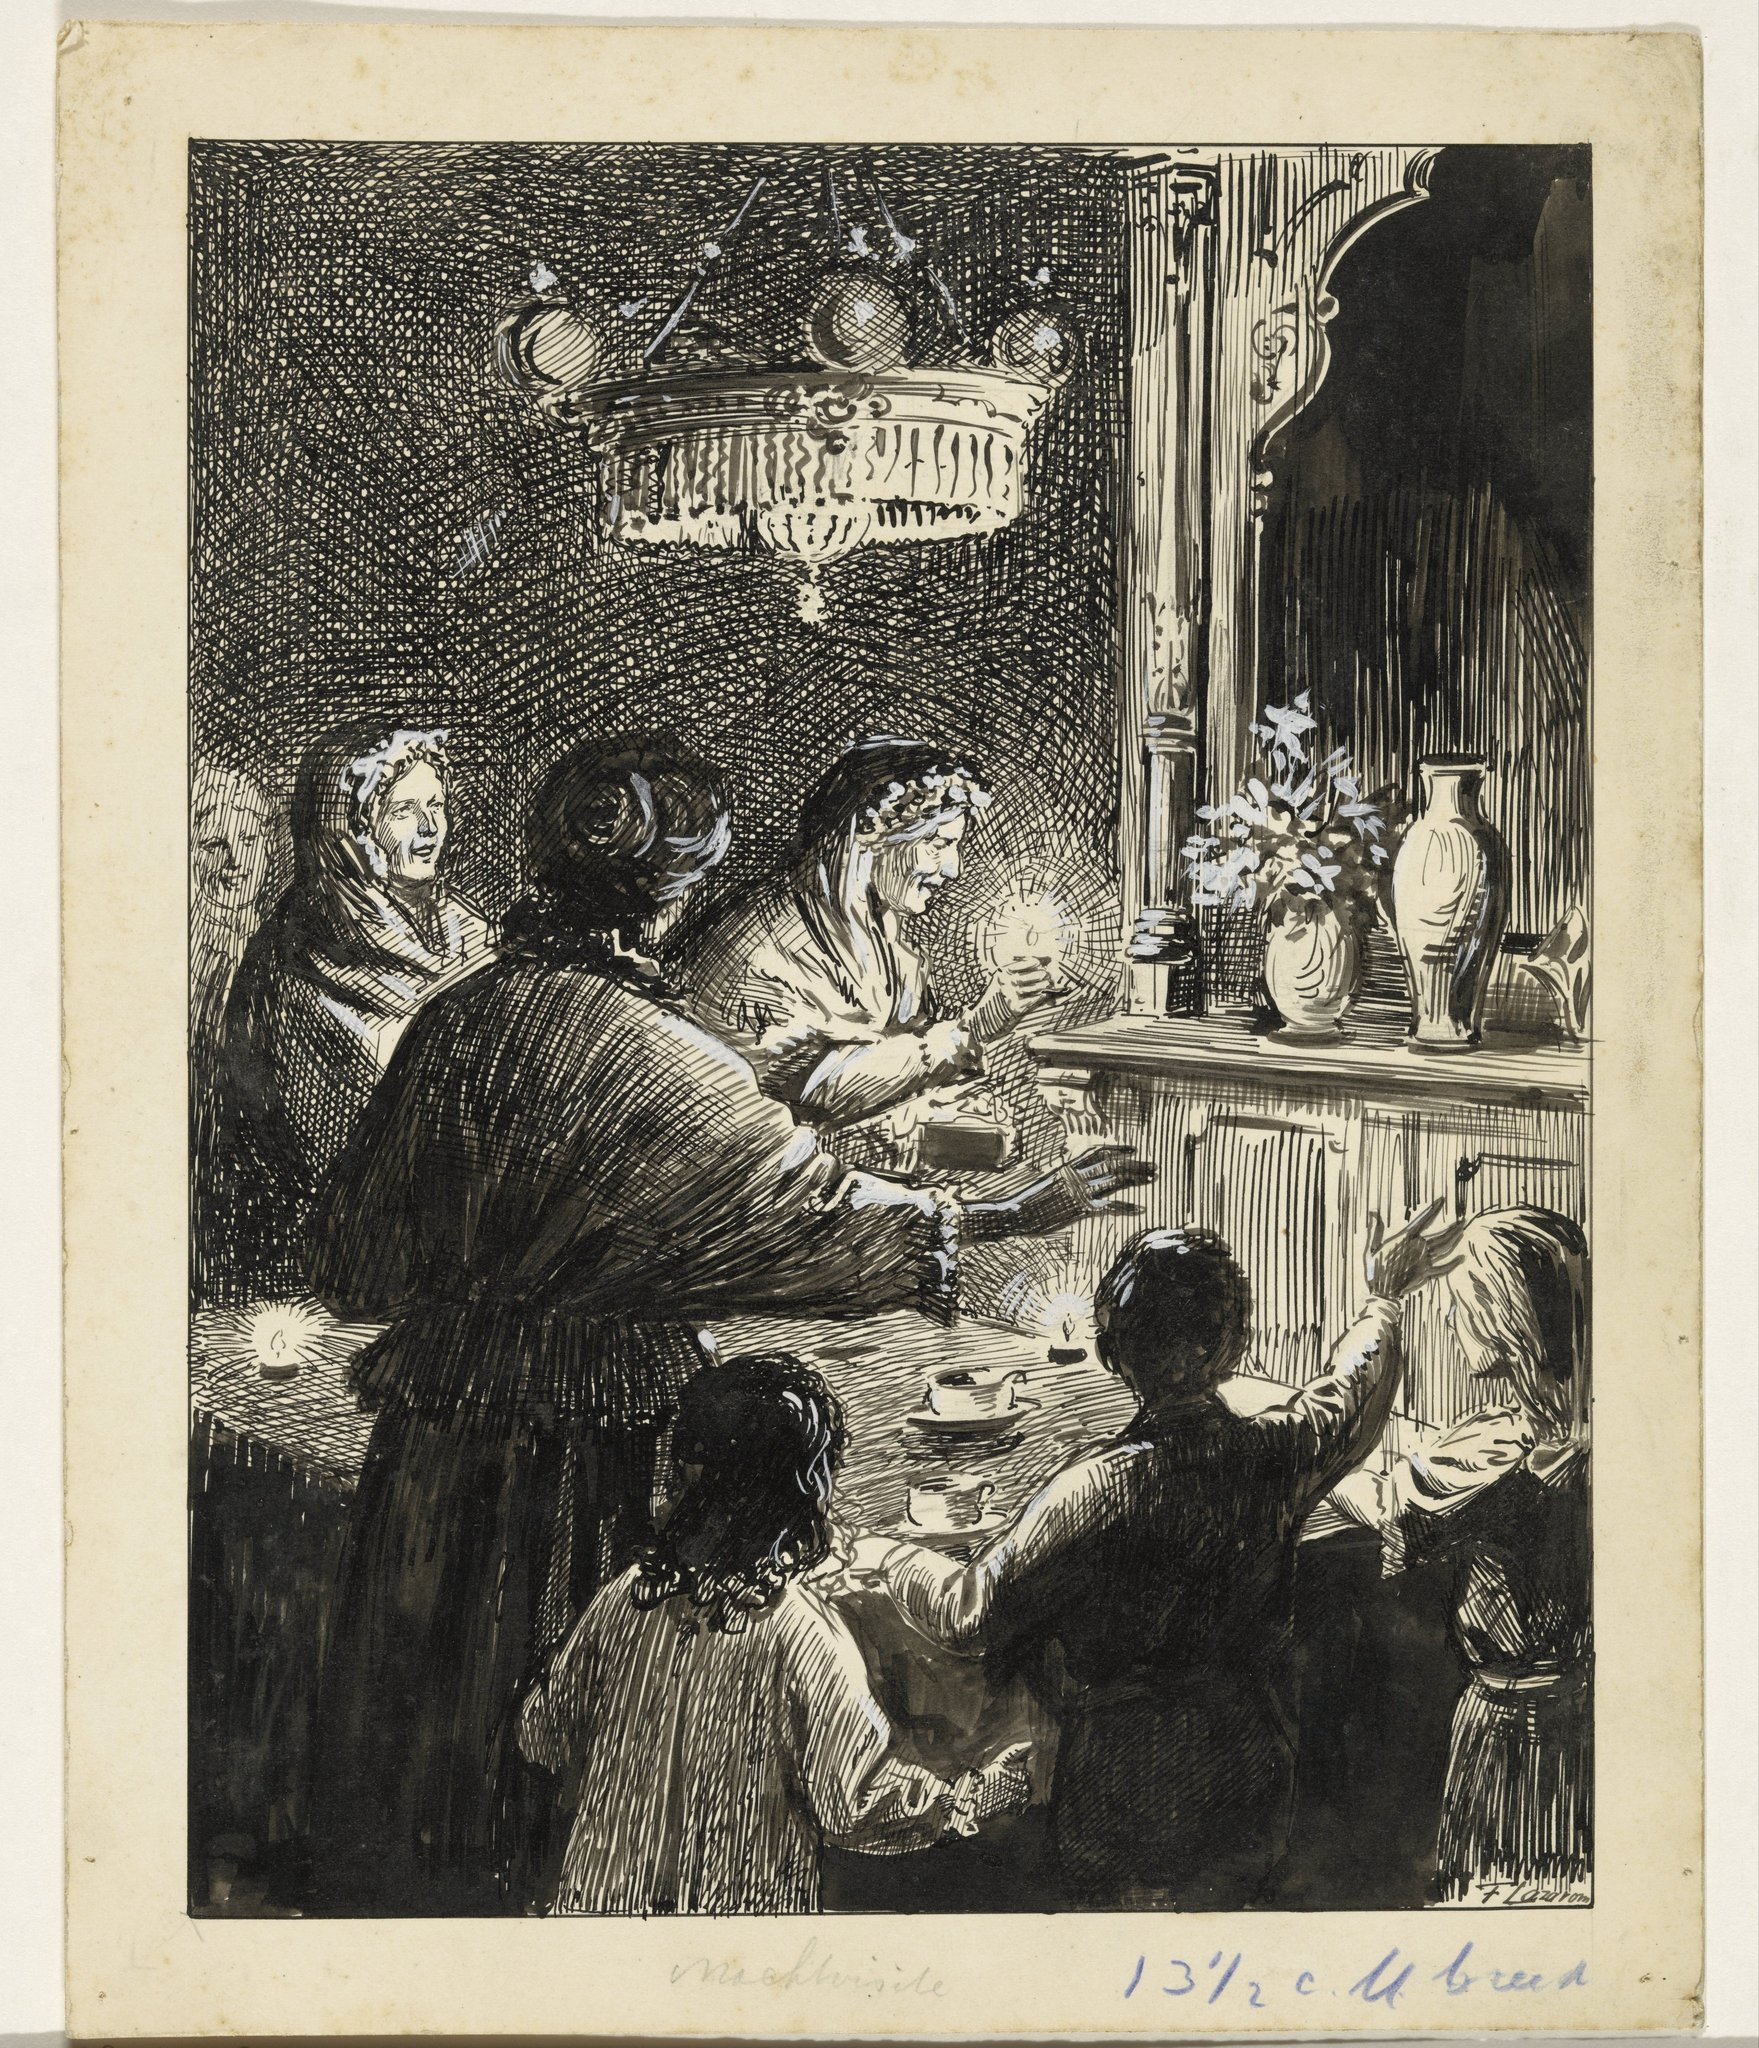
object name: boekillustratie ontwerp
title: Gezelschap rond een tafel bij nacht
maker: frans lazarom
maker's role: draughtsman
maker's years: 1880-1936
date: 1890-1936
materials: paint, ink, paper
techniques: brush, pen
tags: family group, especially parents with their child(ren), candle, night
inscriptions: :, annotation: ‘nachtvisite’, collector's mark: Lugt 2228, signature: ‘F Lazarom’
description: Een gezelschap bestaande uit vier vrouwen en drie kinderen staat rond een tafel bij een schoorsteenmantel in het donker. Op de tafel staan kopjes en brandt een kaars. Eén van de vrouwen houdt een brandende kaars omhoog.